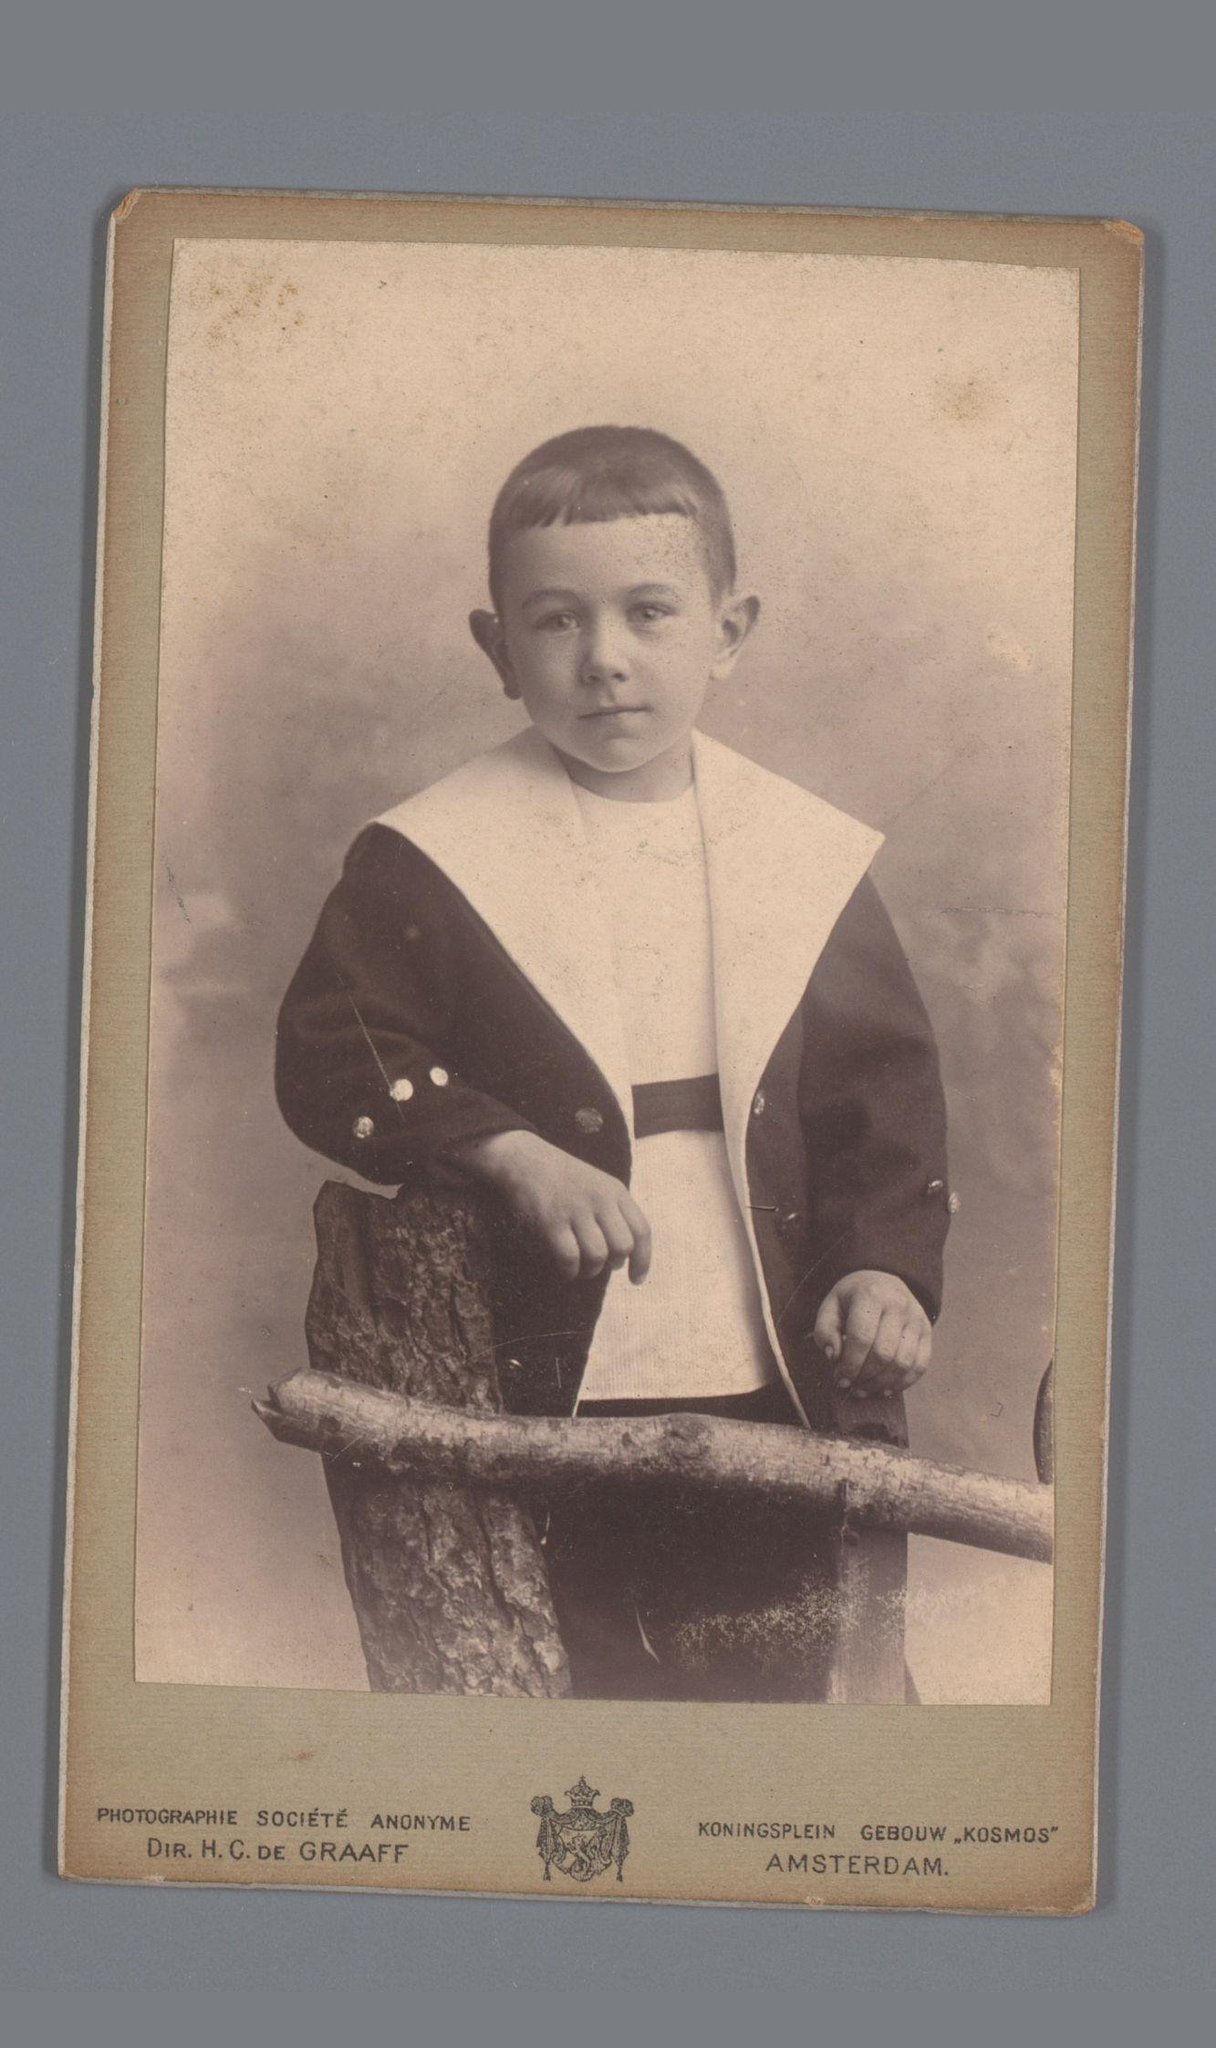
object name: photograph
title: Portret van een onbekende jongen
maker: h.c. de graaff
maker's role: fotograaf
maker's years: 1853-1932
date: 1882-1900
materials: cardboard, paper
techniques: albumen print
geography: amsterdam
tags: boy (child between toddler and youth), historical persons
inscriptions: inscription: ‘Photographie Société anonyme/ Dir. H. C. de Graaff/ Koningsplein gebouw "Kosmos"/ AMSTERDAM./ Het Negatif blijft voor nabestellingen bewaard.’